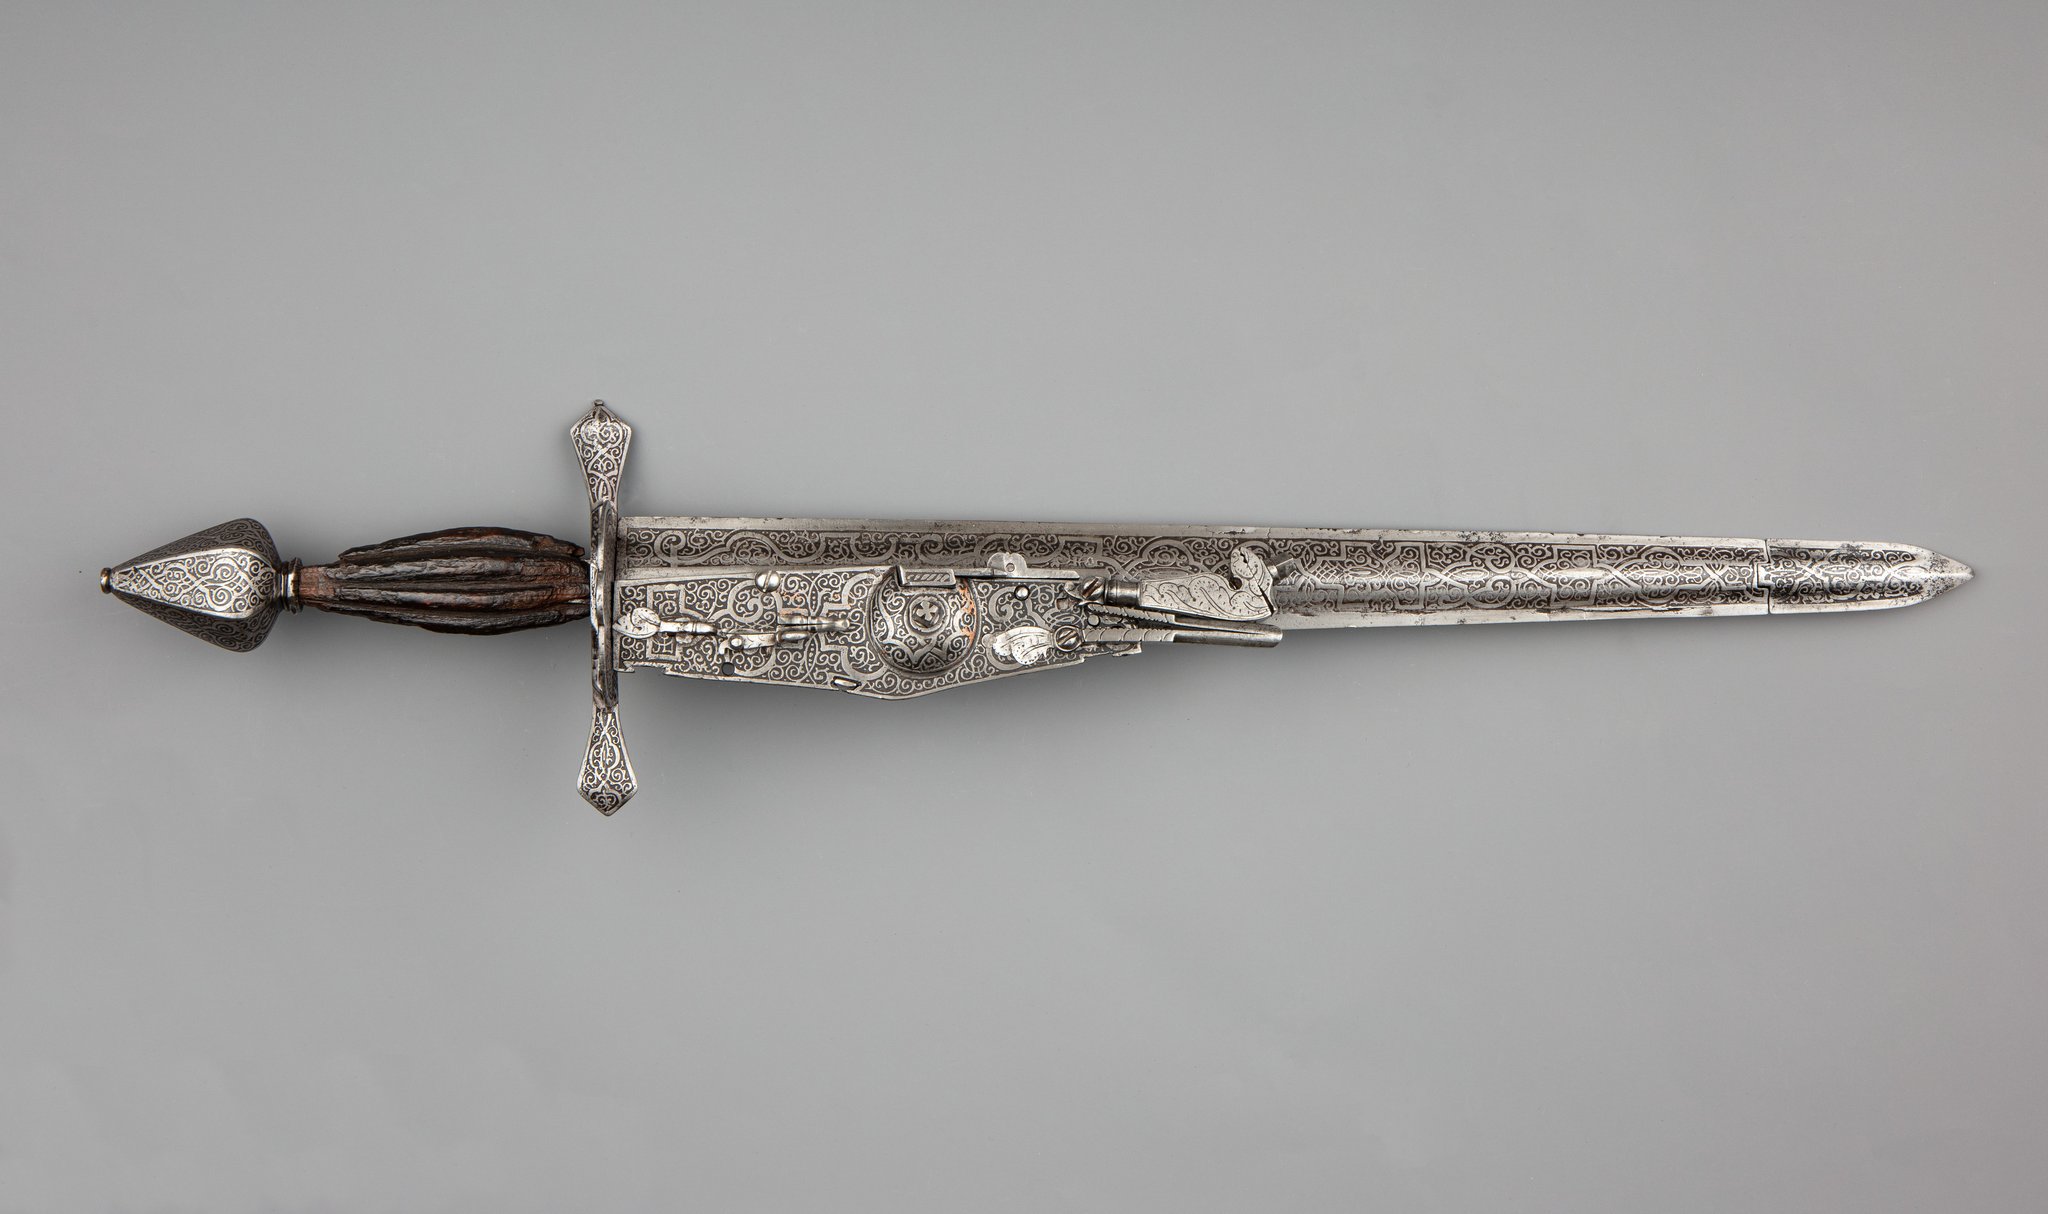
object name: combination weapon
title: Combination Dagger and Wheellock Pistol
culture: german, saxony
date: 1575-1600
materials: steel, wood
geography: germany